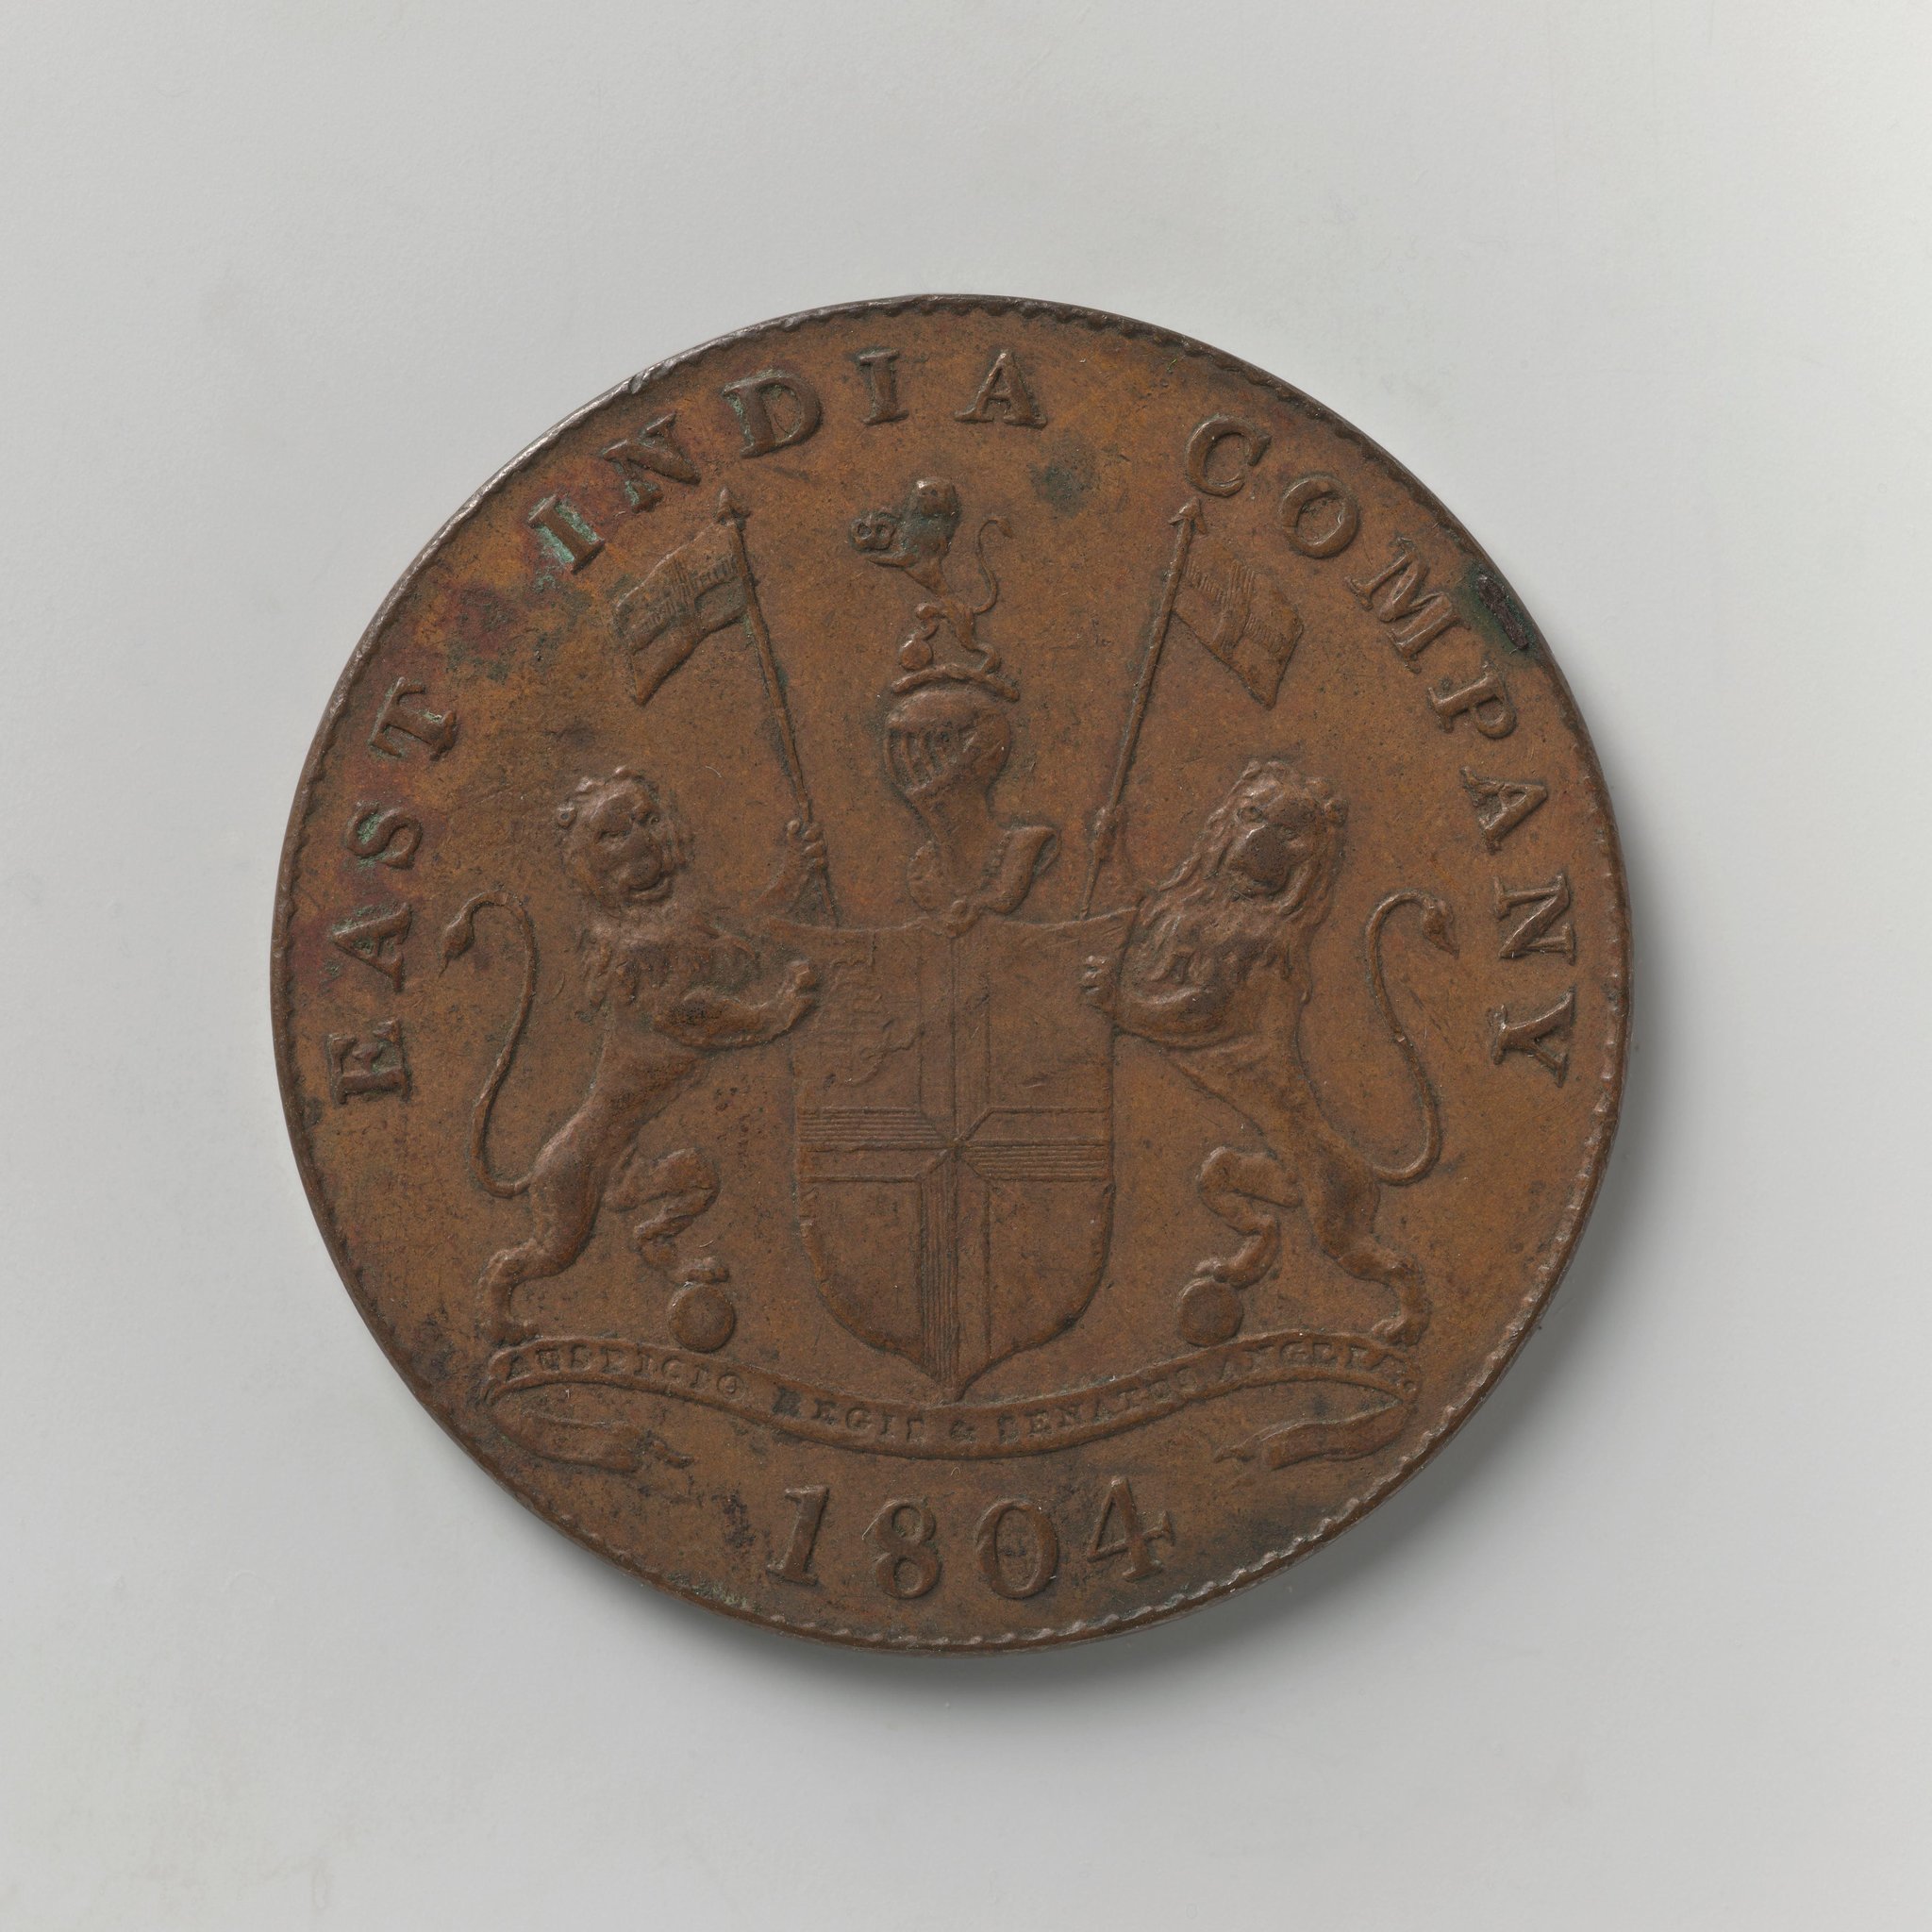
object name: coin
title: Singapore, 4 kepengs,1804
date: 1823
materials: copper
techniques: striking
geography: birmingham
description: Koperen munt. Voorzijde: door twee leeuwen gehouden wapenschild van de Engelse Oostindische Compagnie, waarboven aanduiding East India Company en waaronder wapenspreuk. Daaronder bevroren jaartal 1804. Keerzijde: op een regel in het Maleis waarde-aanduiding: ampat kepeng. Daarboven cijfer: 4 in Arabische cijfers en daaronder jaartal in Islamitische tijdsrekening en in Arabische cijfers. Gladde rand.